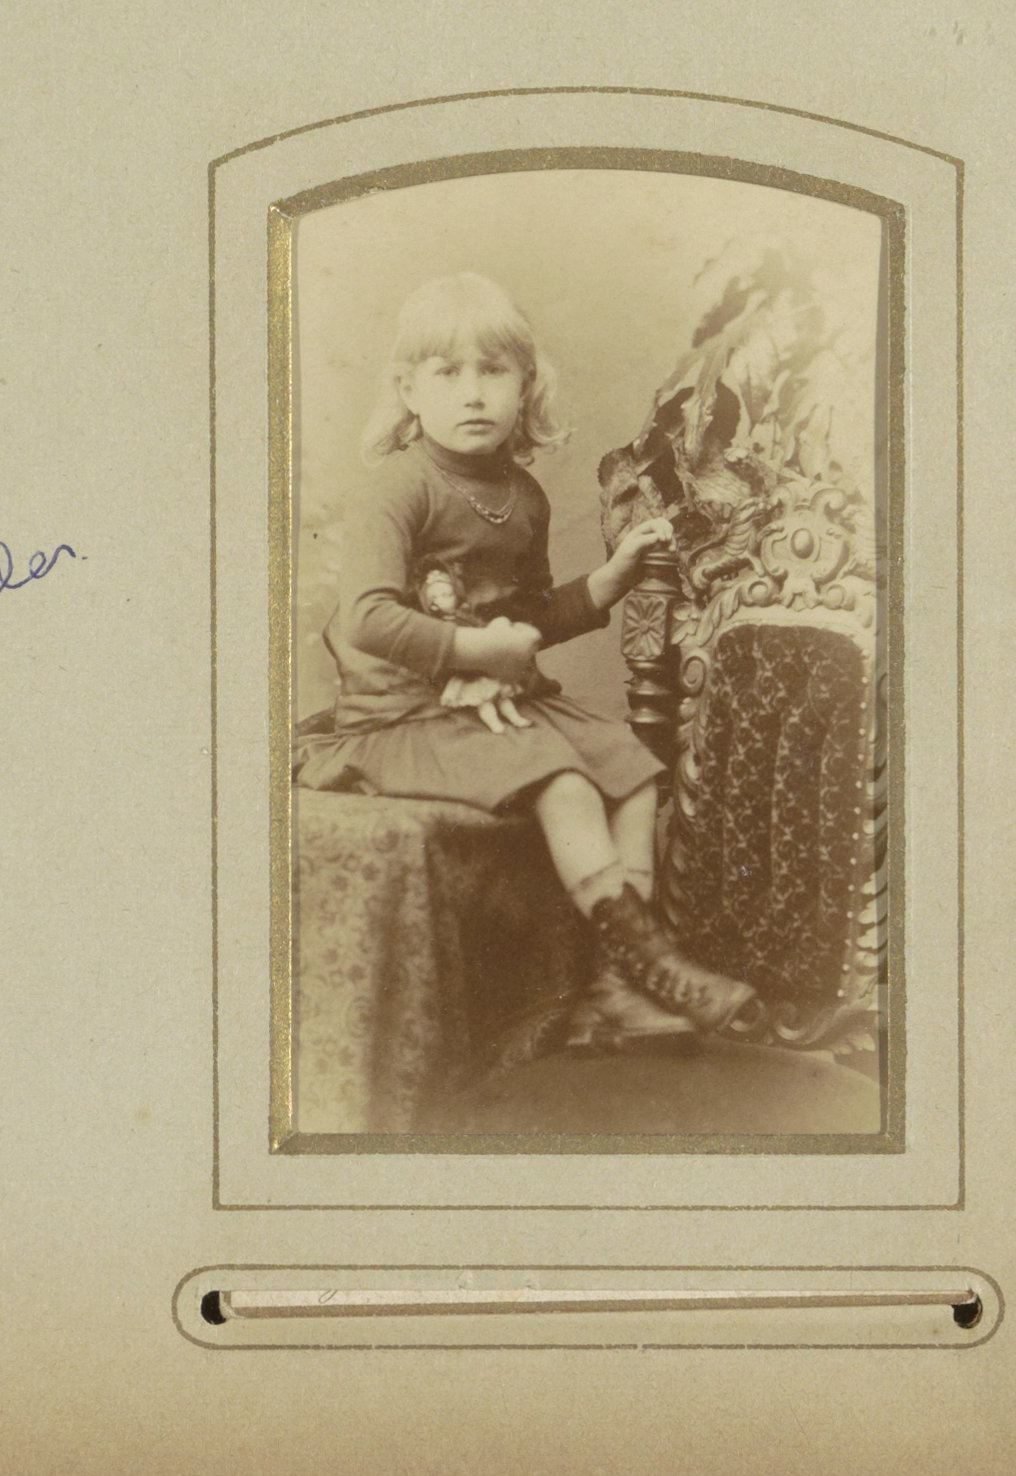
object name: carte de visite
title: Portret van Henriette Boelen als 4-jarig kind, zittend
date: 1881-1884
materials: cardboard, paper, photographic support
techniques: albumen print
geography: amsterdam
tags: studio requisites ~ photographer, historical persons - bb - woman, child, amsterdam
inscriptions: inscription: ‘Jetje 4 jaar’, address: ‘128 P.C. Hooftstraat Amsterdam’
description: Onderdeel van Fotoalbum van de familie Boelen.